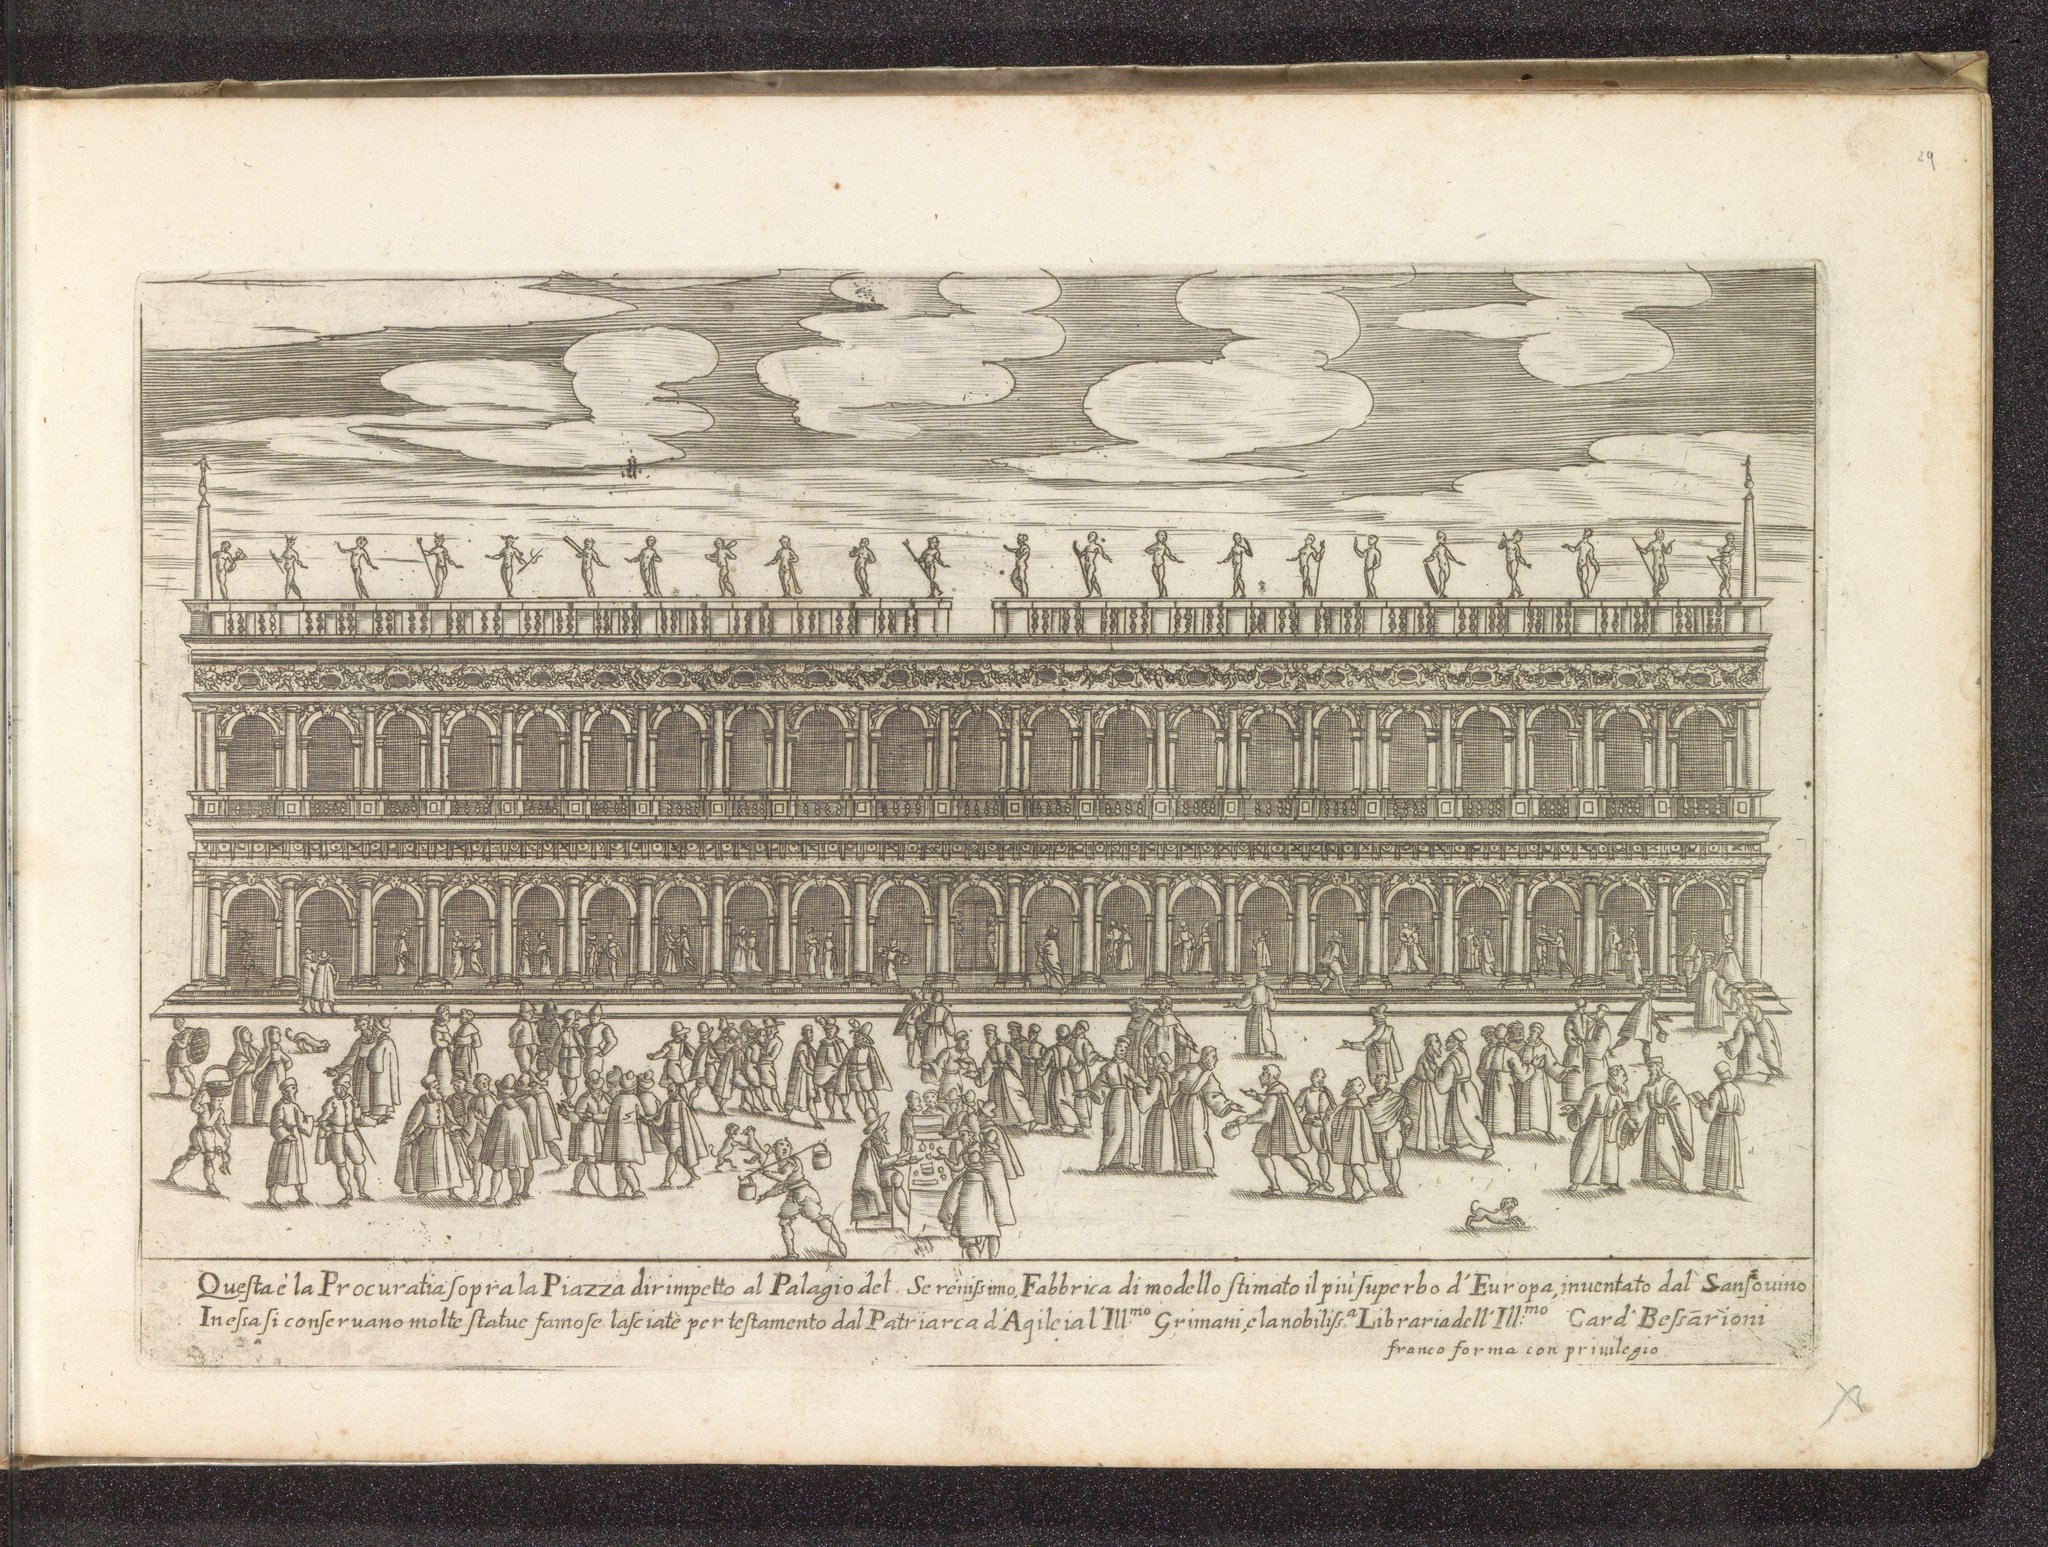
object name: print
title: Façade van de Biblioteca Marciana te Venetië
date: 1610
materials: paper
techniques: engraving, etching, intaglio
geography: italy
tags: square, place, circus, etc., city-view in general; 'veduta', public library, venice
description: Façade van de Biblioteca Marciana met op de voorgrond bedrijvigheid op het Piazzetta. Tweeregelige Italiaanse tekst in ondermarge. De prent maakt deel uit van een album.